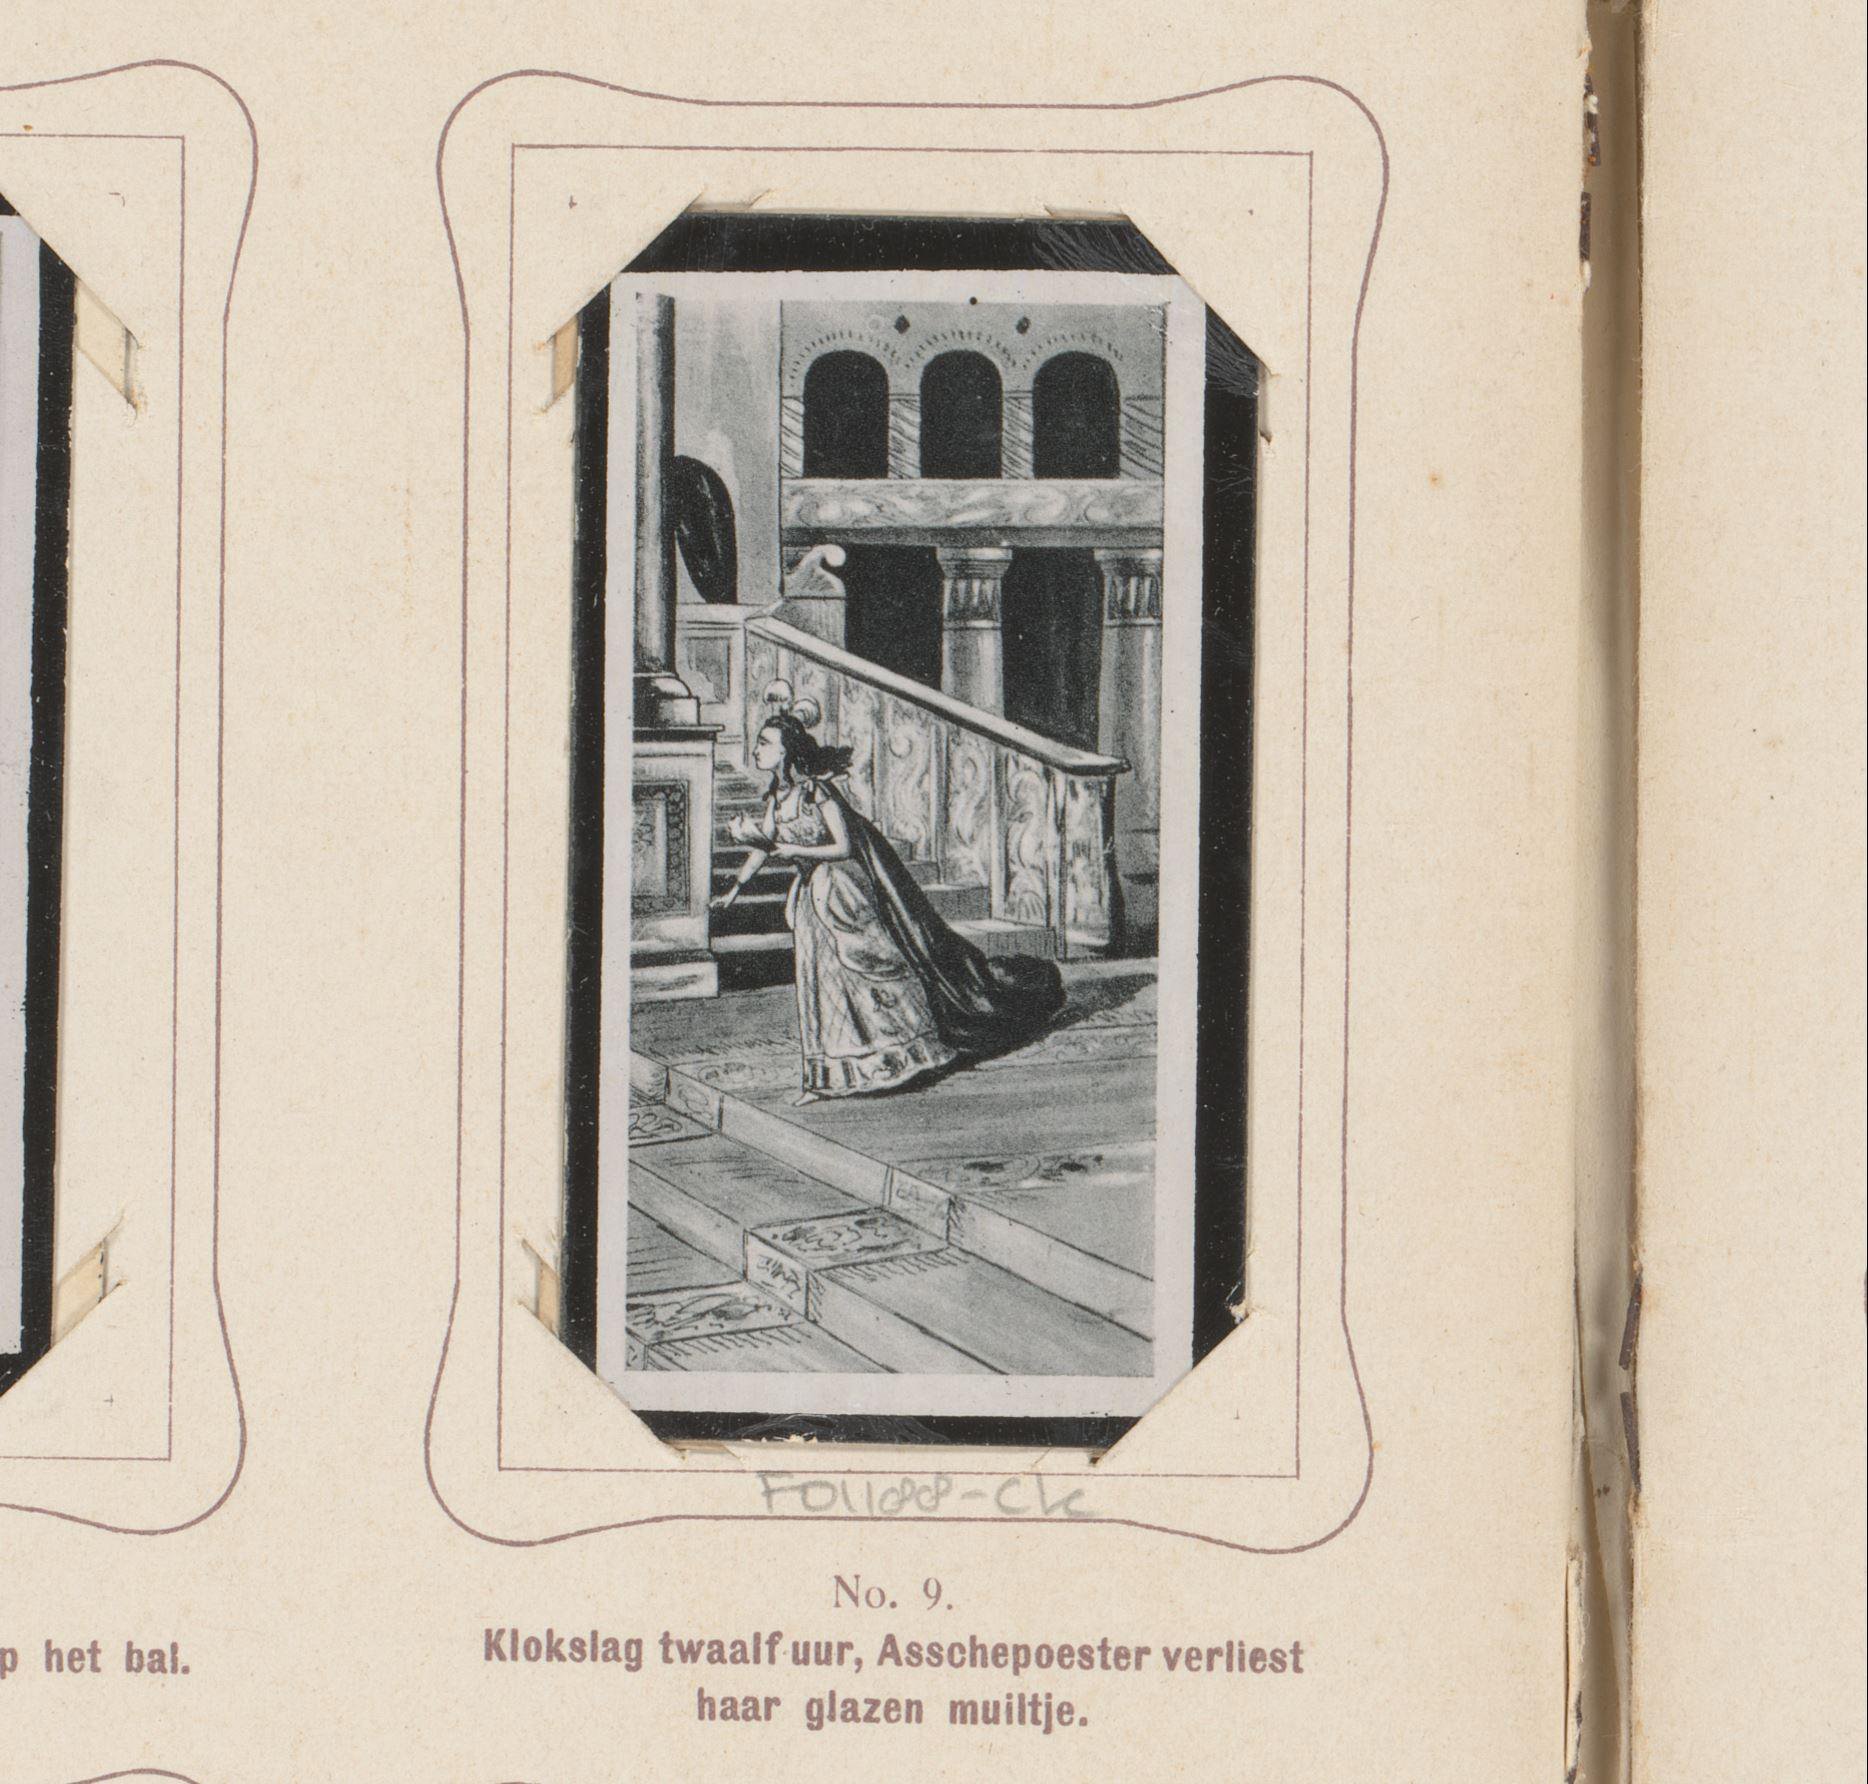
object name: photomechanical print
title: Reproductie van een tekening van Assepoester die haar glazen muiltje verliest op het bal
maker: Anonymous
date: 1906-1907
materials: paper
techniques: photograph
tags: tales and fairy tales (with title)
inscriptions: inscription: ‘No. 9./ Klokslag twaalf uur, Asschepoester verliest haar glazen muiltje.’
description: Deze prent maakt deel uit van een album.